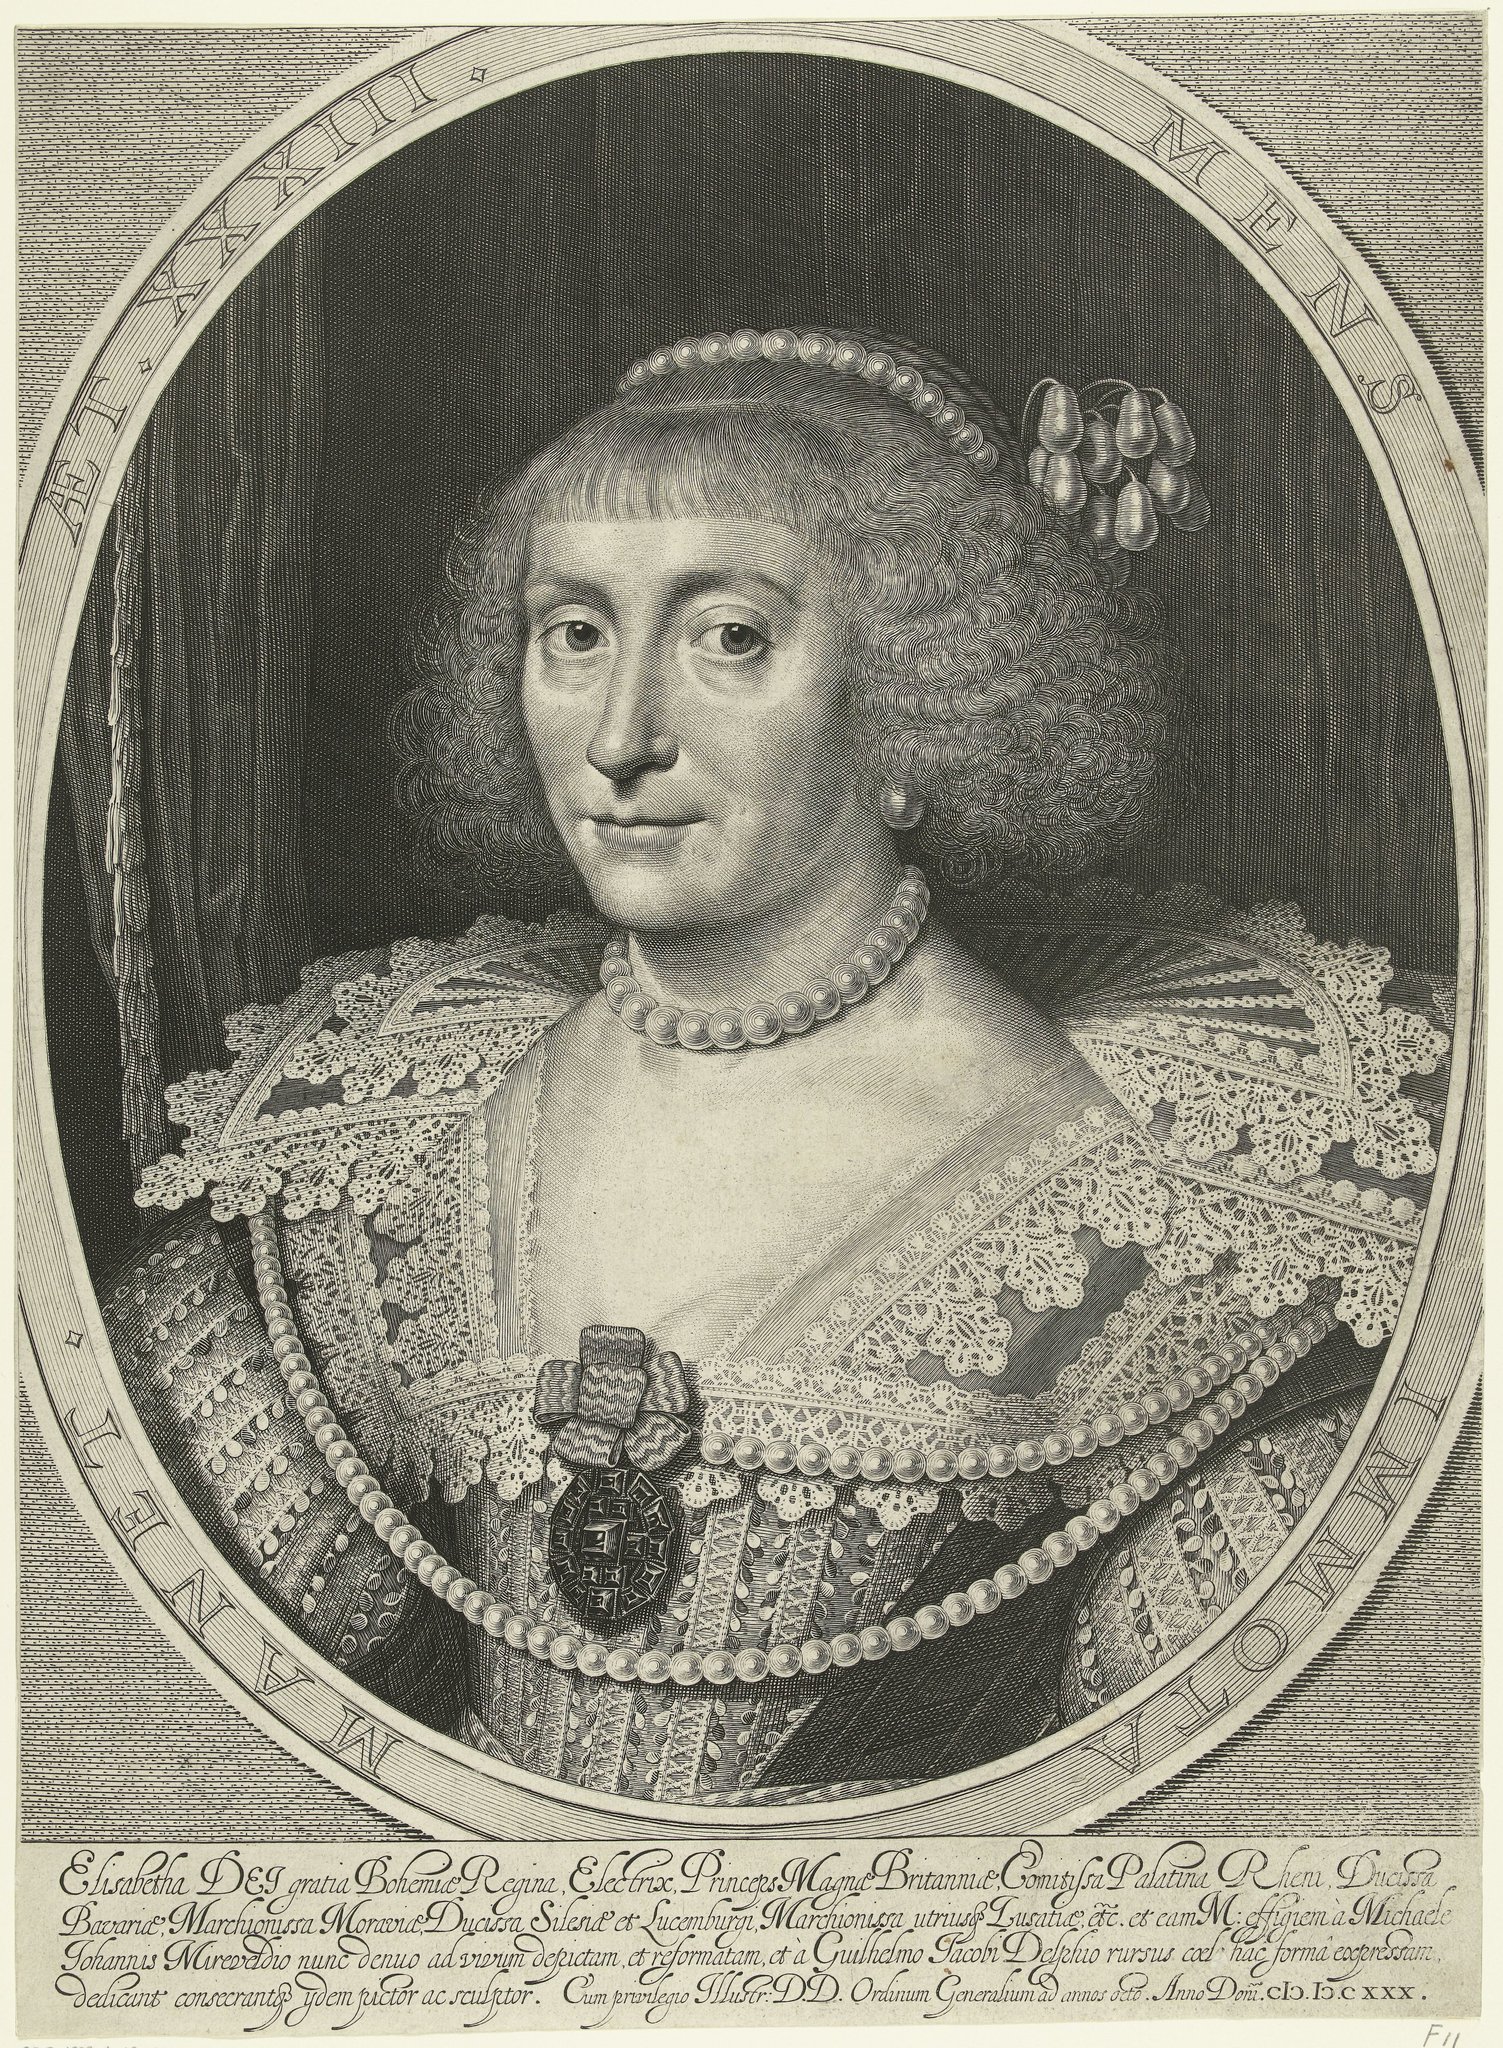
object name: print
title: Portret van Elisabeth Stuart, keurvorstin van de Palts, koningin van Bohemen op 33-jarige leeftijd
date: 1630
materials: paper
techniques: engraving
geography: delft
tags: london, ruler, sovereign - bb - female ruler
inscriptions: collector's mark: Lugt 2228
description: Portret van Elisabeth Stuart, keurvorstin van de Palts, koningin van Bohemen, op 33-jarige leeftijd, borststuk met kanten kraag, hoofdsieraad en parelsnoeren. Ovale omlijsting met Latijns motto, Latijns opschrift in vier regels in ondermarge.